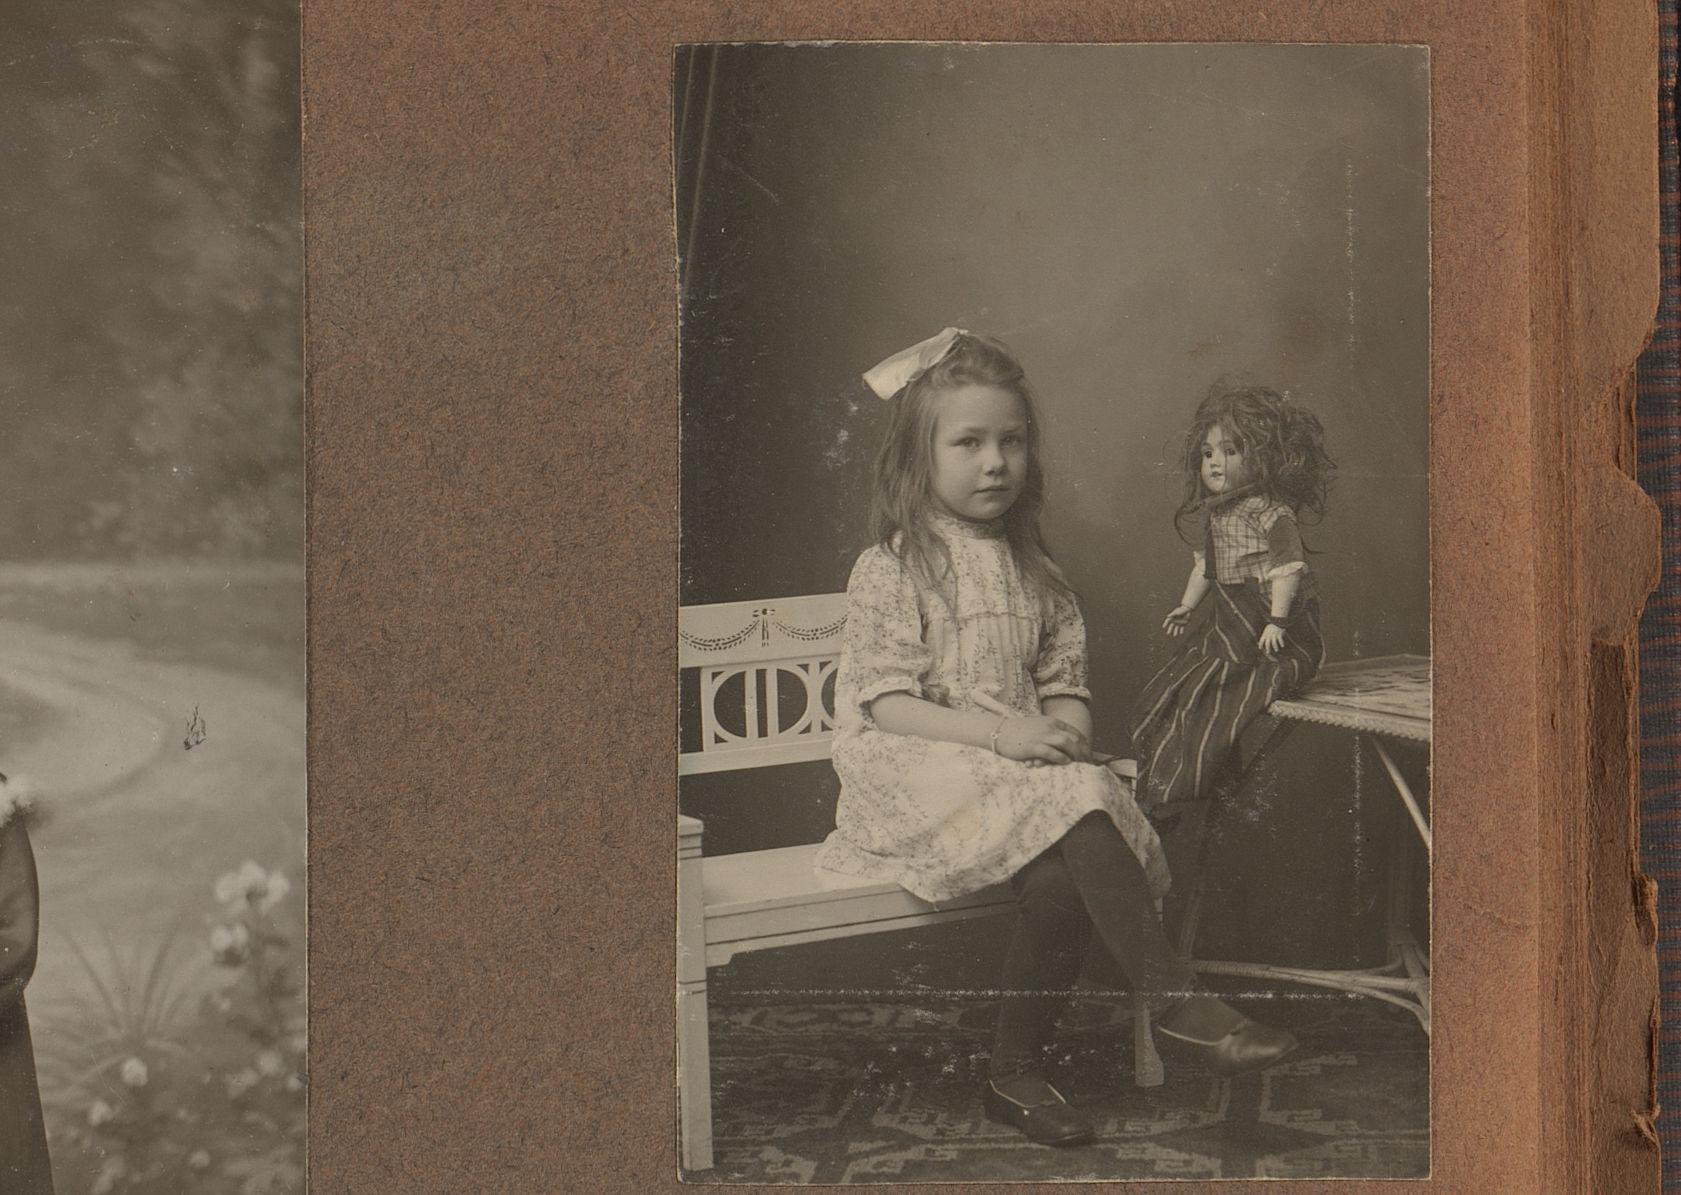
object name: photograph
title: Studioportret Thea Diepenbrock met pop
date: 1911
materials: photographic support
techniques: photography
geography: netherlands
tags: thea diepenbrock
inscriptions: inscription: ‘1911’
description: Foto op bruin albumblad 17 van familiealbum van Alphons Diepenbrock.